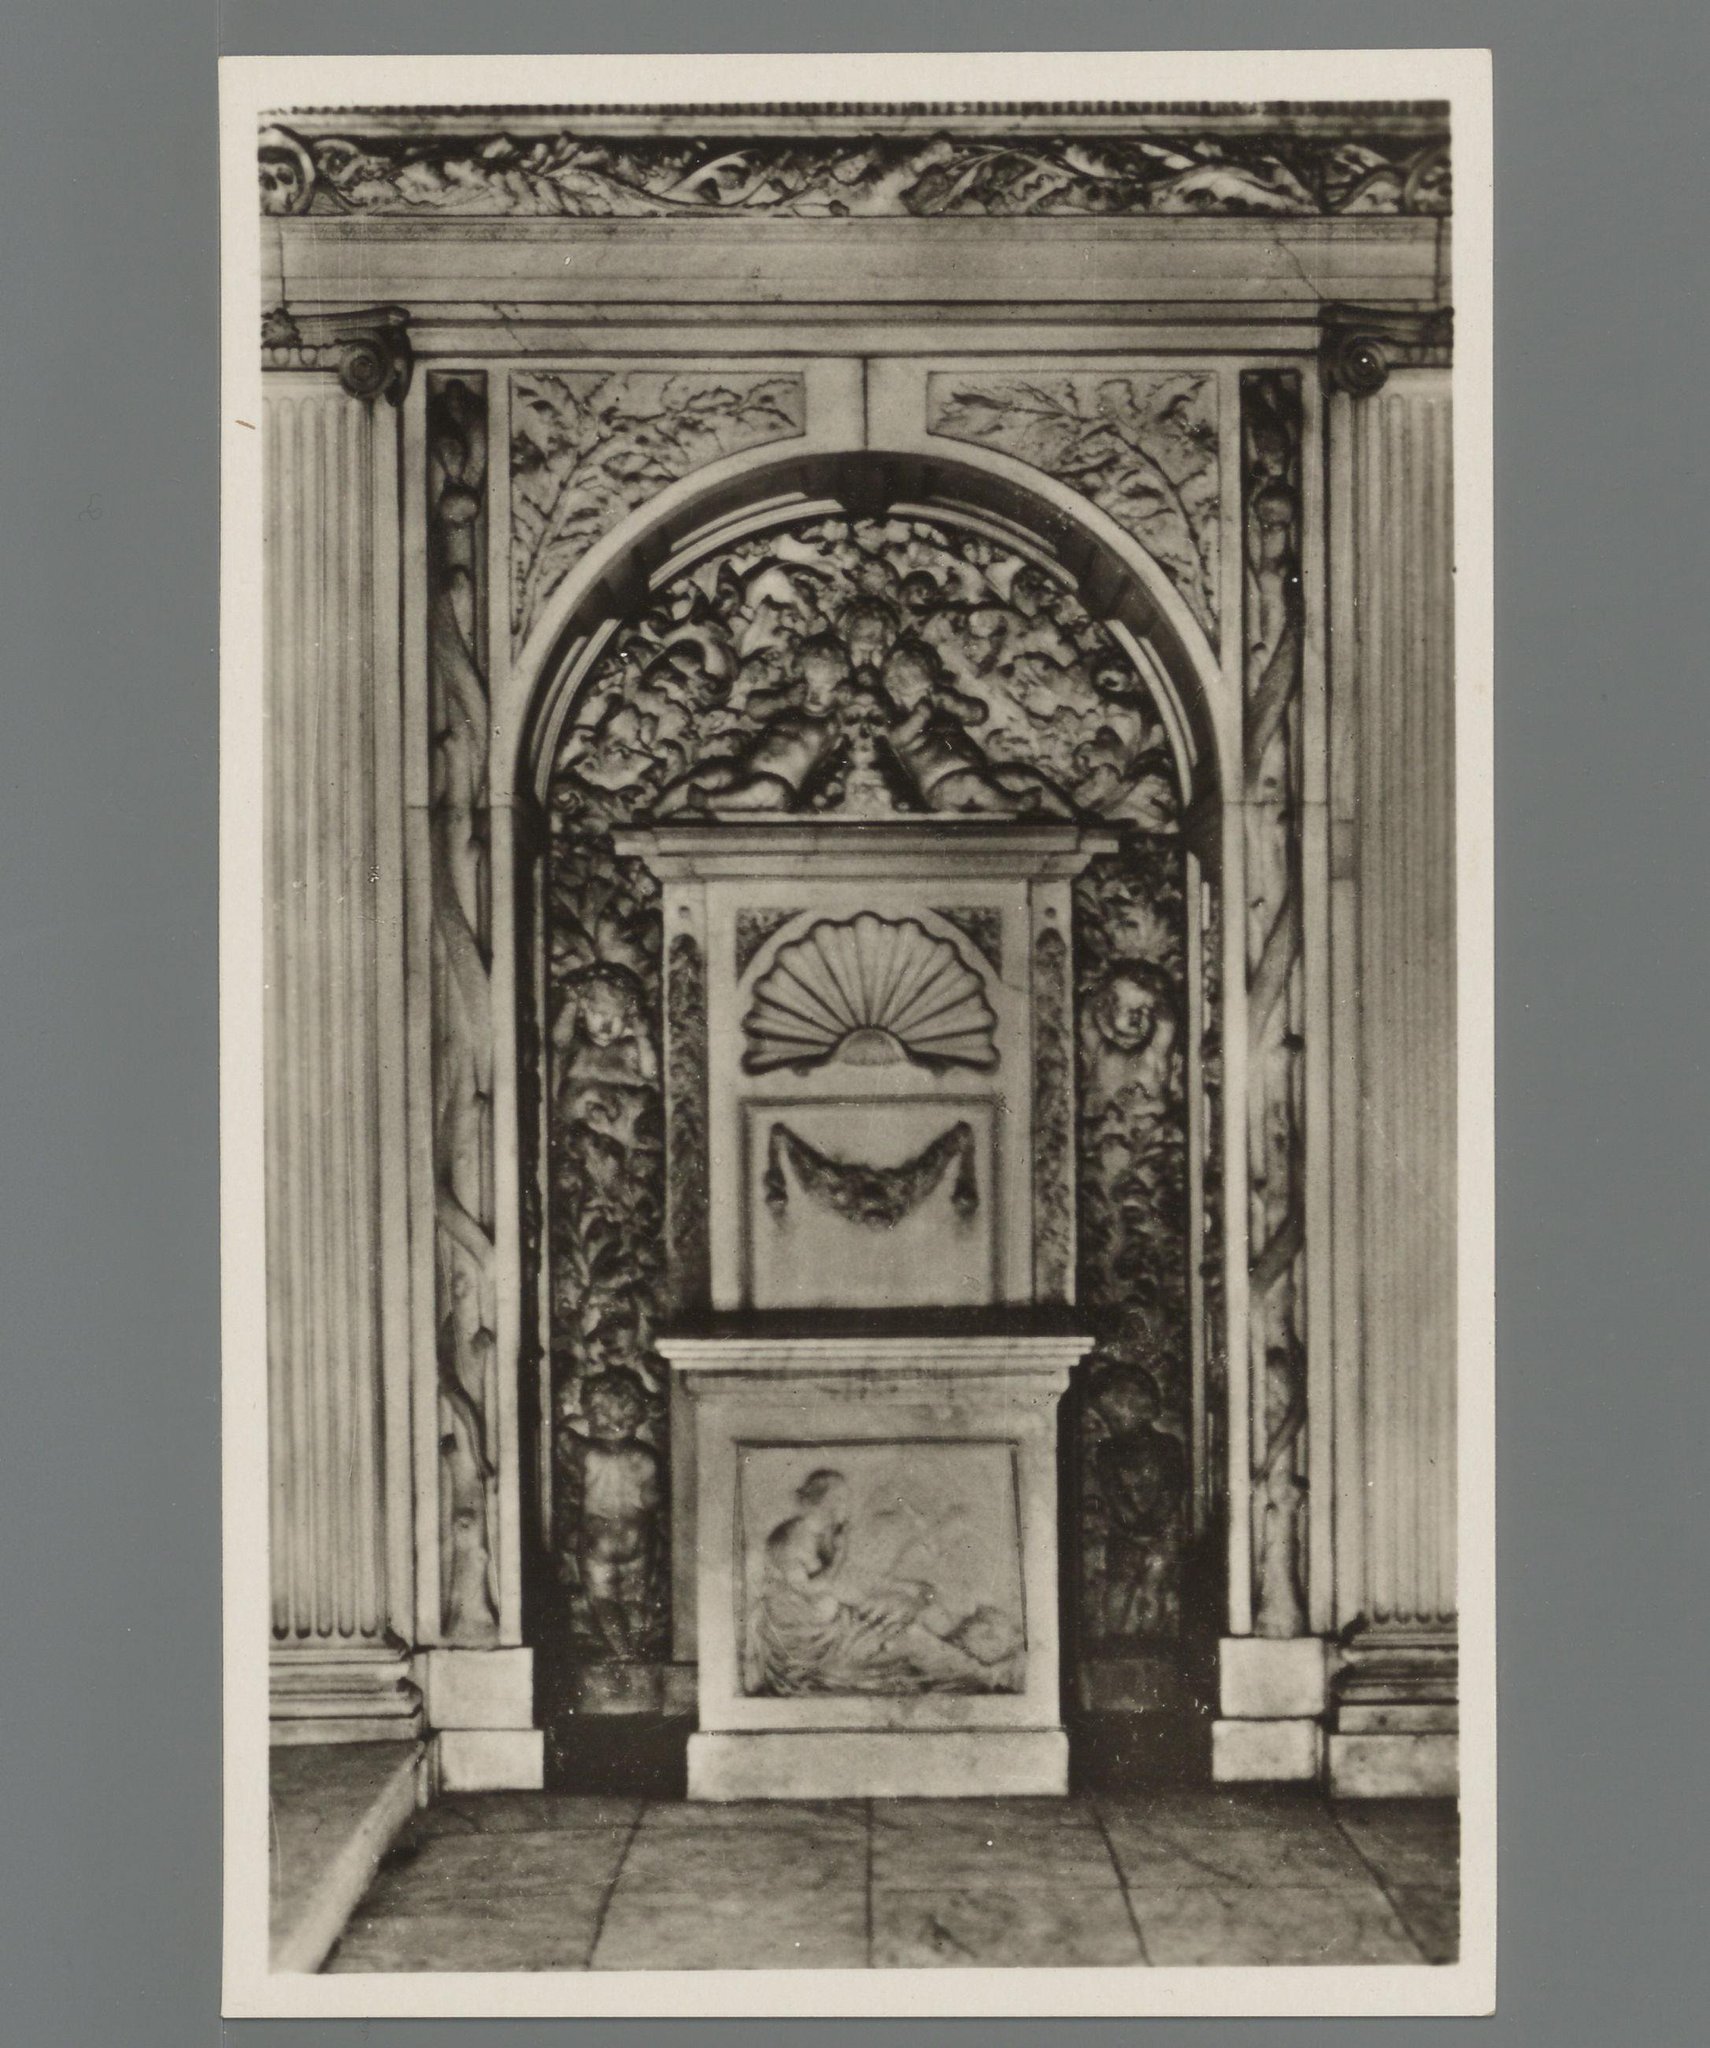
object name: ansichtkaart, prentbriefkaart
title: De Vierschaar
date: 1932-1947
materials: photographic support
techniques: photography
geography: amsterdam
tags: palace - aa - civic architecture: inside, administration of justice, trial, interior ~ representation of a building, royal palace of amsterdam